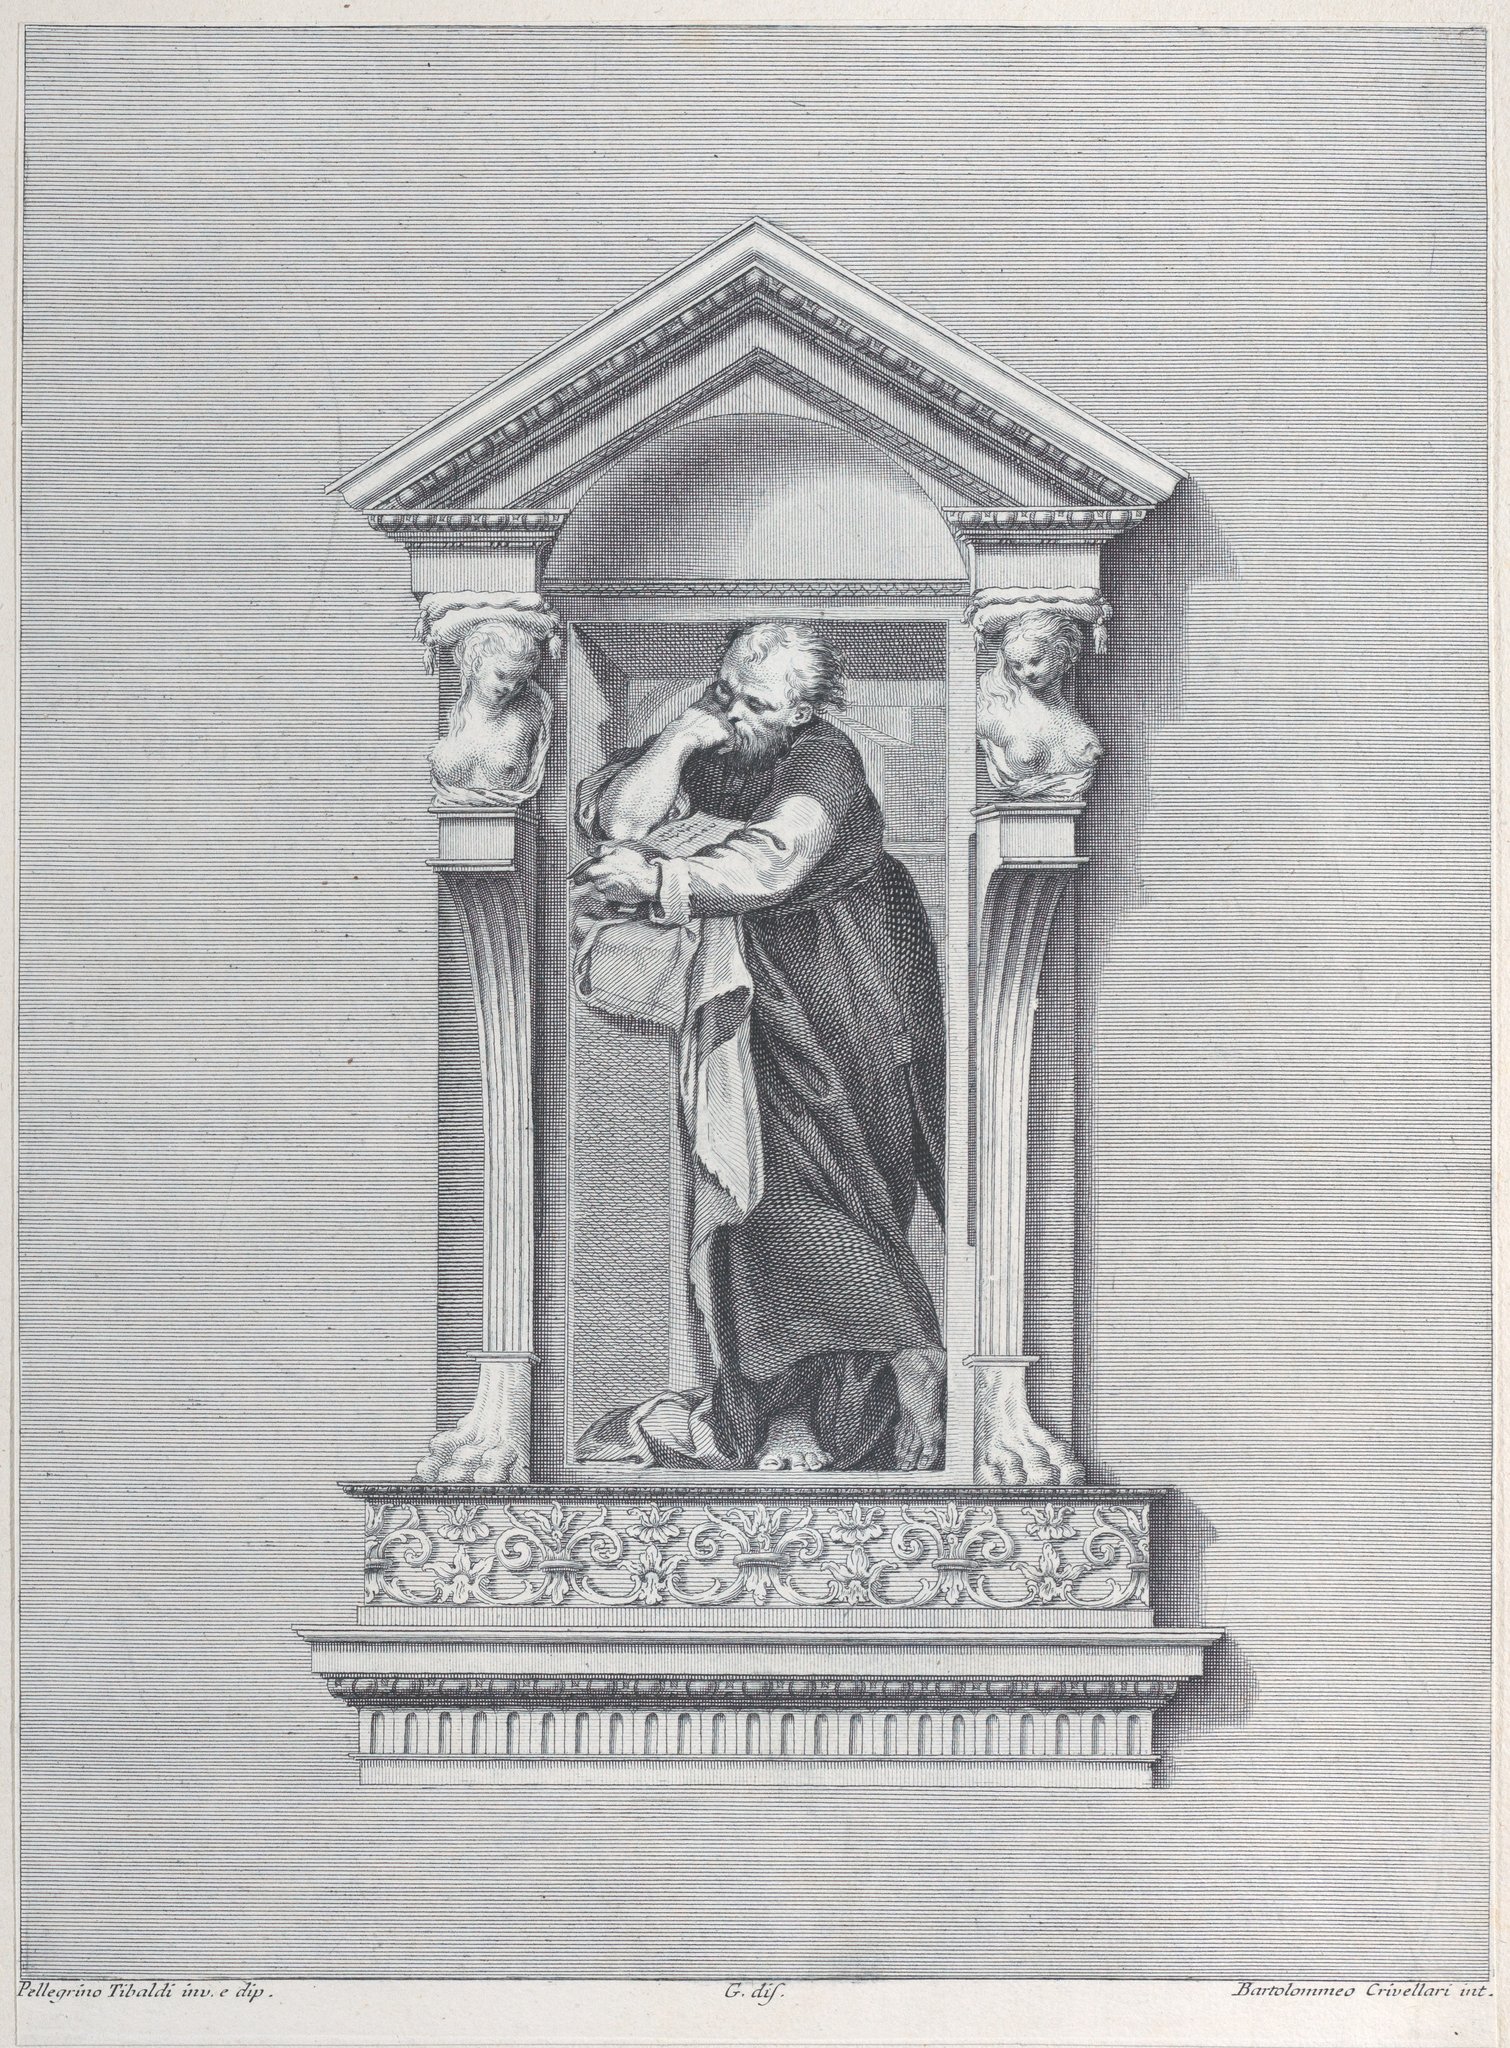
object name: print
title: A standing man in a niche with his elbow resting on a column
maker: bartolomeo crivellari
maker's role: artist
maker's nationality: italian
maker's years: 1700-1800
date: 1756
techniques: engraving, etching